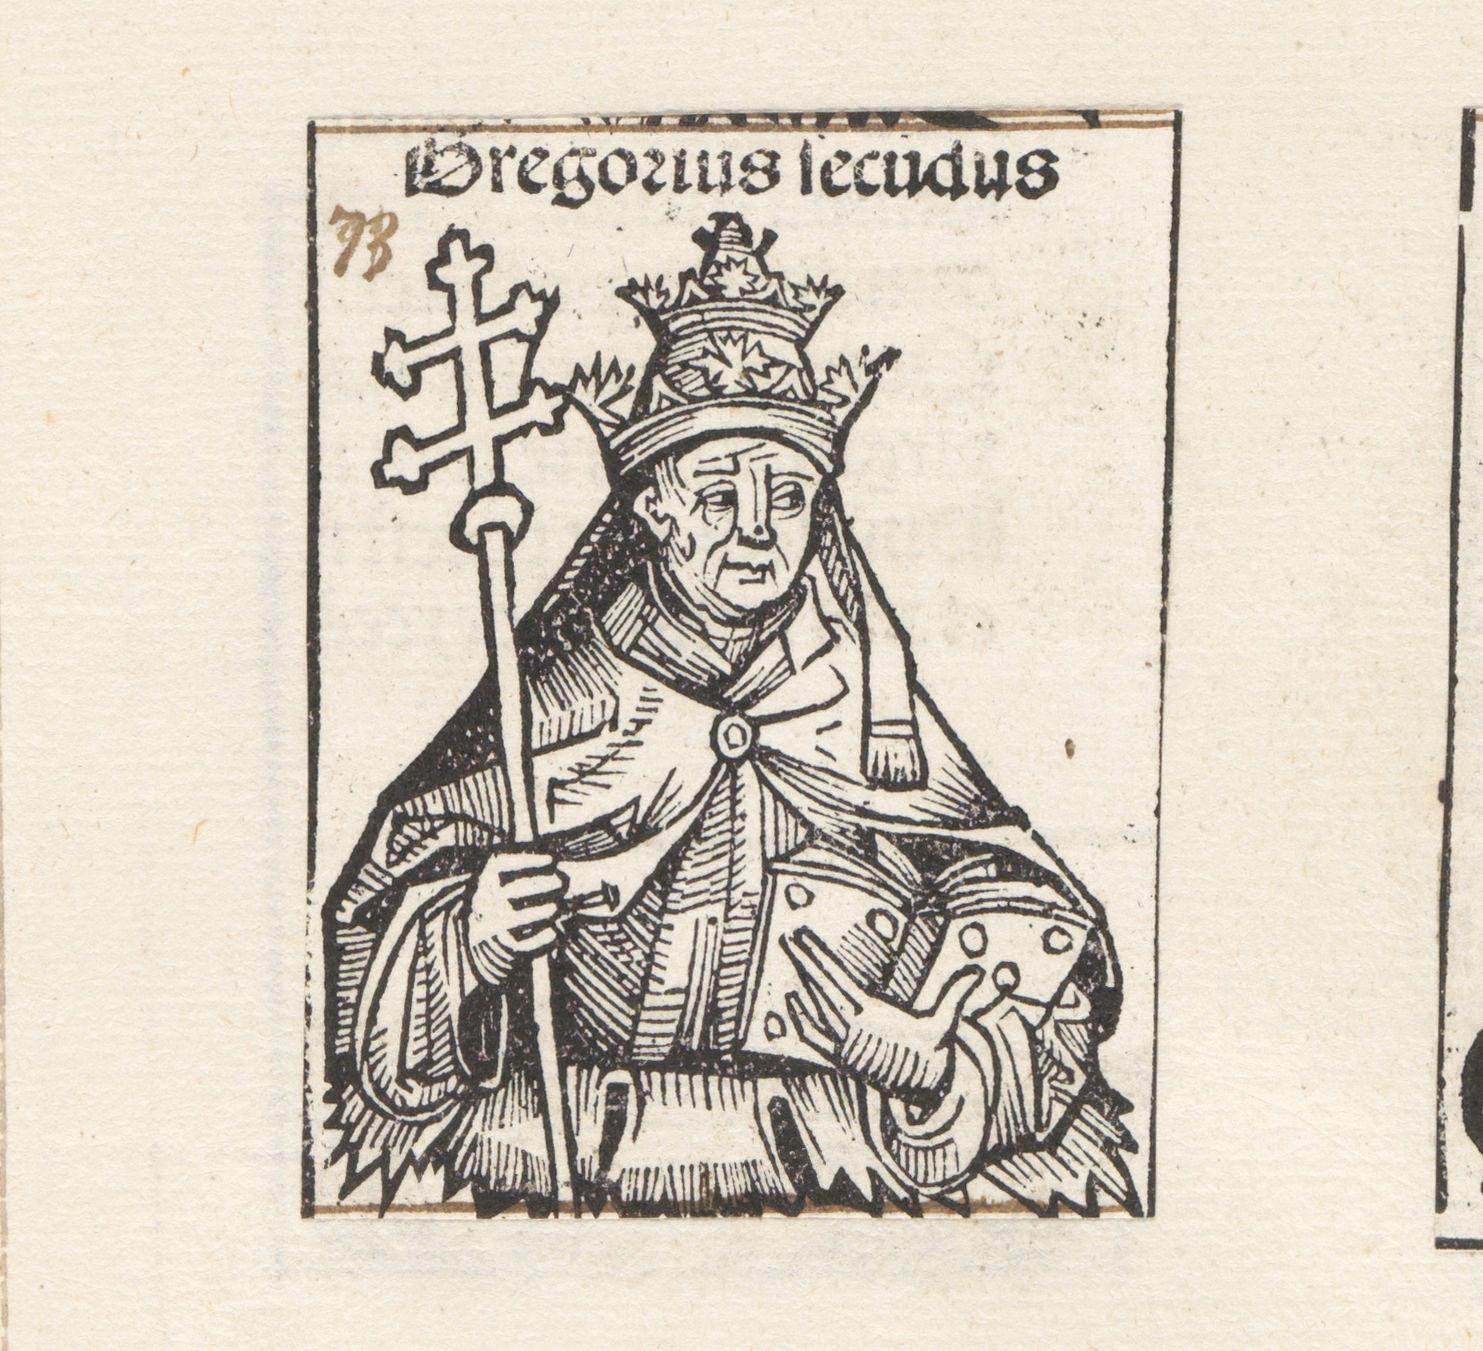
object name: print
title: Gregorius secundus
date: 1493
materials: paper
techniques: letterpress printing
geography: nuremberg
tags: rome, pope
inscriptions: inscription: ‘73’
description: Een bloemkelk met een paus. Hij draagt een tiara en heeft een opengeslagen bijbel en een staf met een dubbel kruis in zijn handen. De voorstelling is onderdeel van de opeenvolging pausen in de Liber Chronicarum. De tekst identificeert de man als Gregorius II. De prent maakt deel uit van een album.